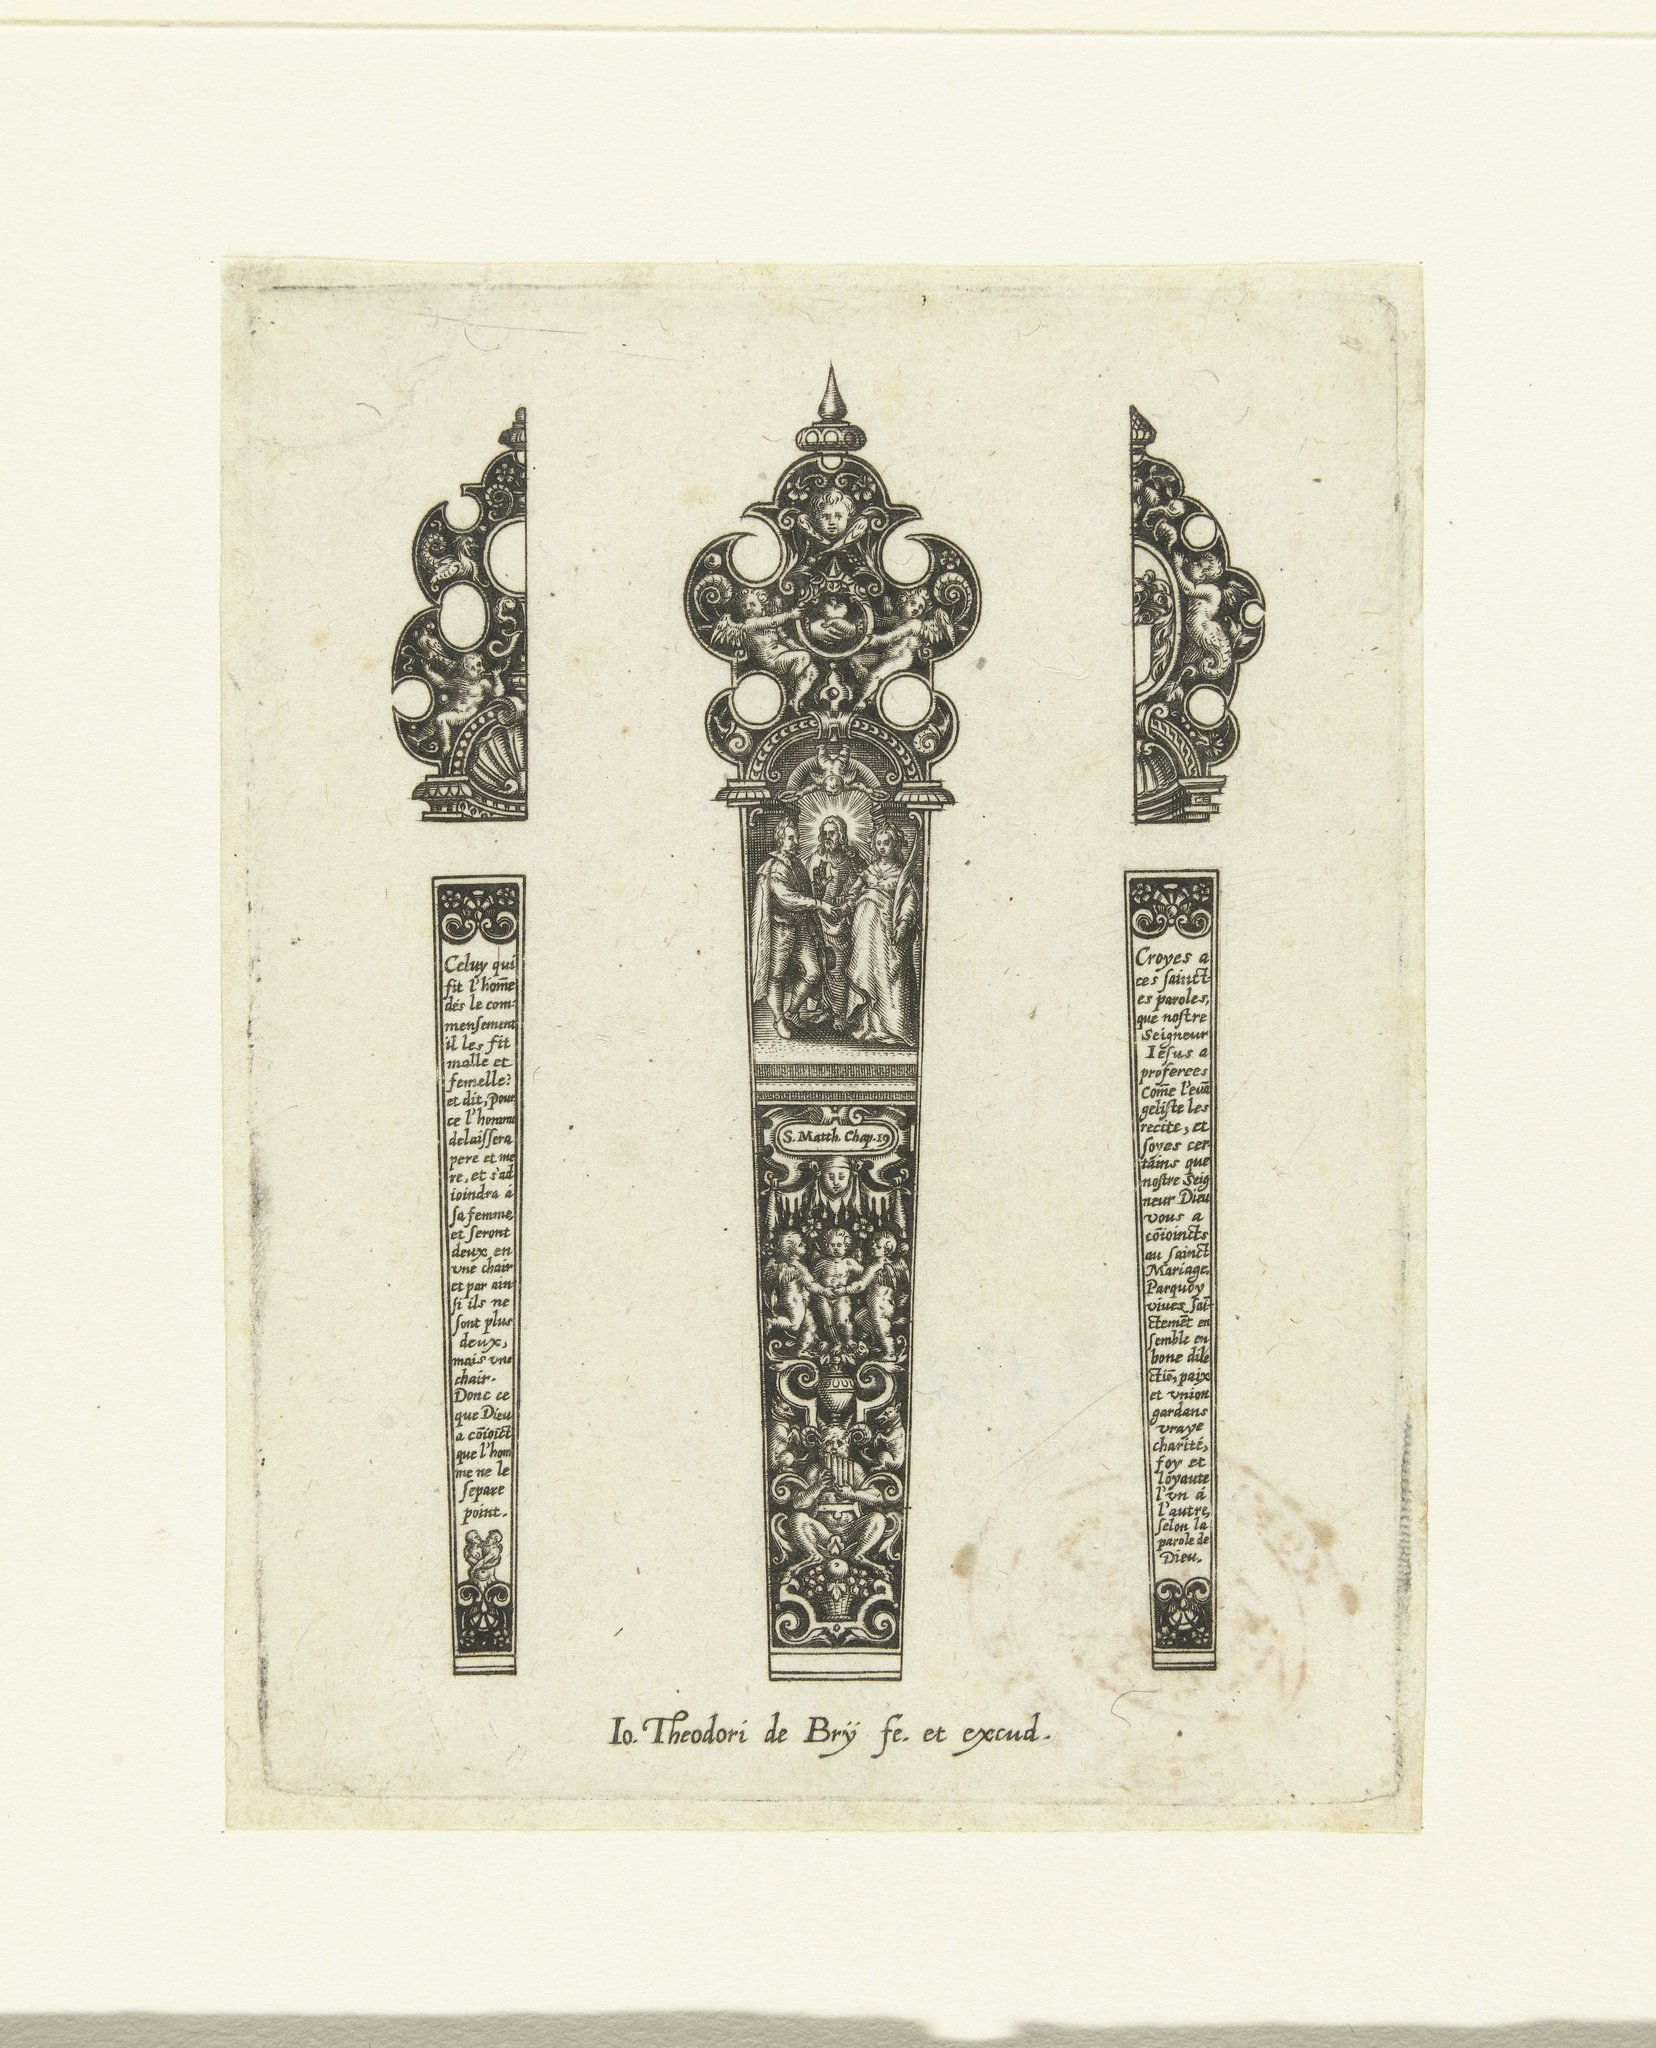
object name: ornament print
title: Messenheft met grotesken, onderaan een gehurkte sater die op een panfluit blaast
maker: johann theodor de bry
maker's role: print maker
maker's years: 1561-1623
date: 1598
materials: paper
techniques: engraving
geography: germany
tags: ornament ~ grotesque, chastity, panpipes, satyr(s) (in general), 'castità matrimoniale', 'fede maritale', 'matrimonio' (ripa)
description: Bovenaan een allegorie op het huwelijk uit kuise liefde. Een van 4 bladen, elk met één ontwerp voor de voorzijde van een heft, geflankeerd door twee halve ontwerpen voor de de achterzijde. De teksten op de achterzijde hebben betrekking op de voorstellingen aan de voorzijde.